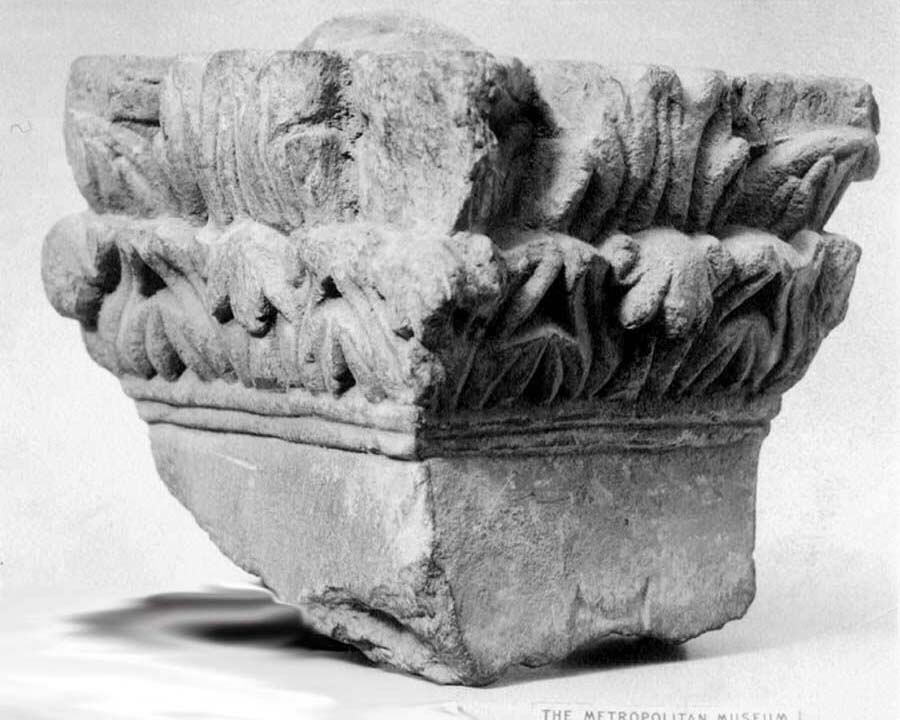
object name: capital study collection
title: Capital (Study Collection)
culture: pakistani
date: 101-300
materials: stone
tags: gandhara